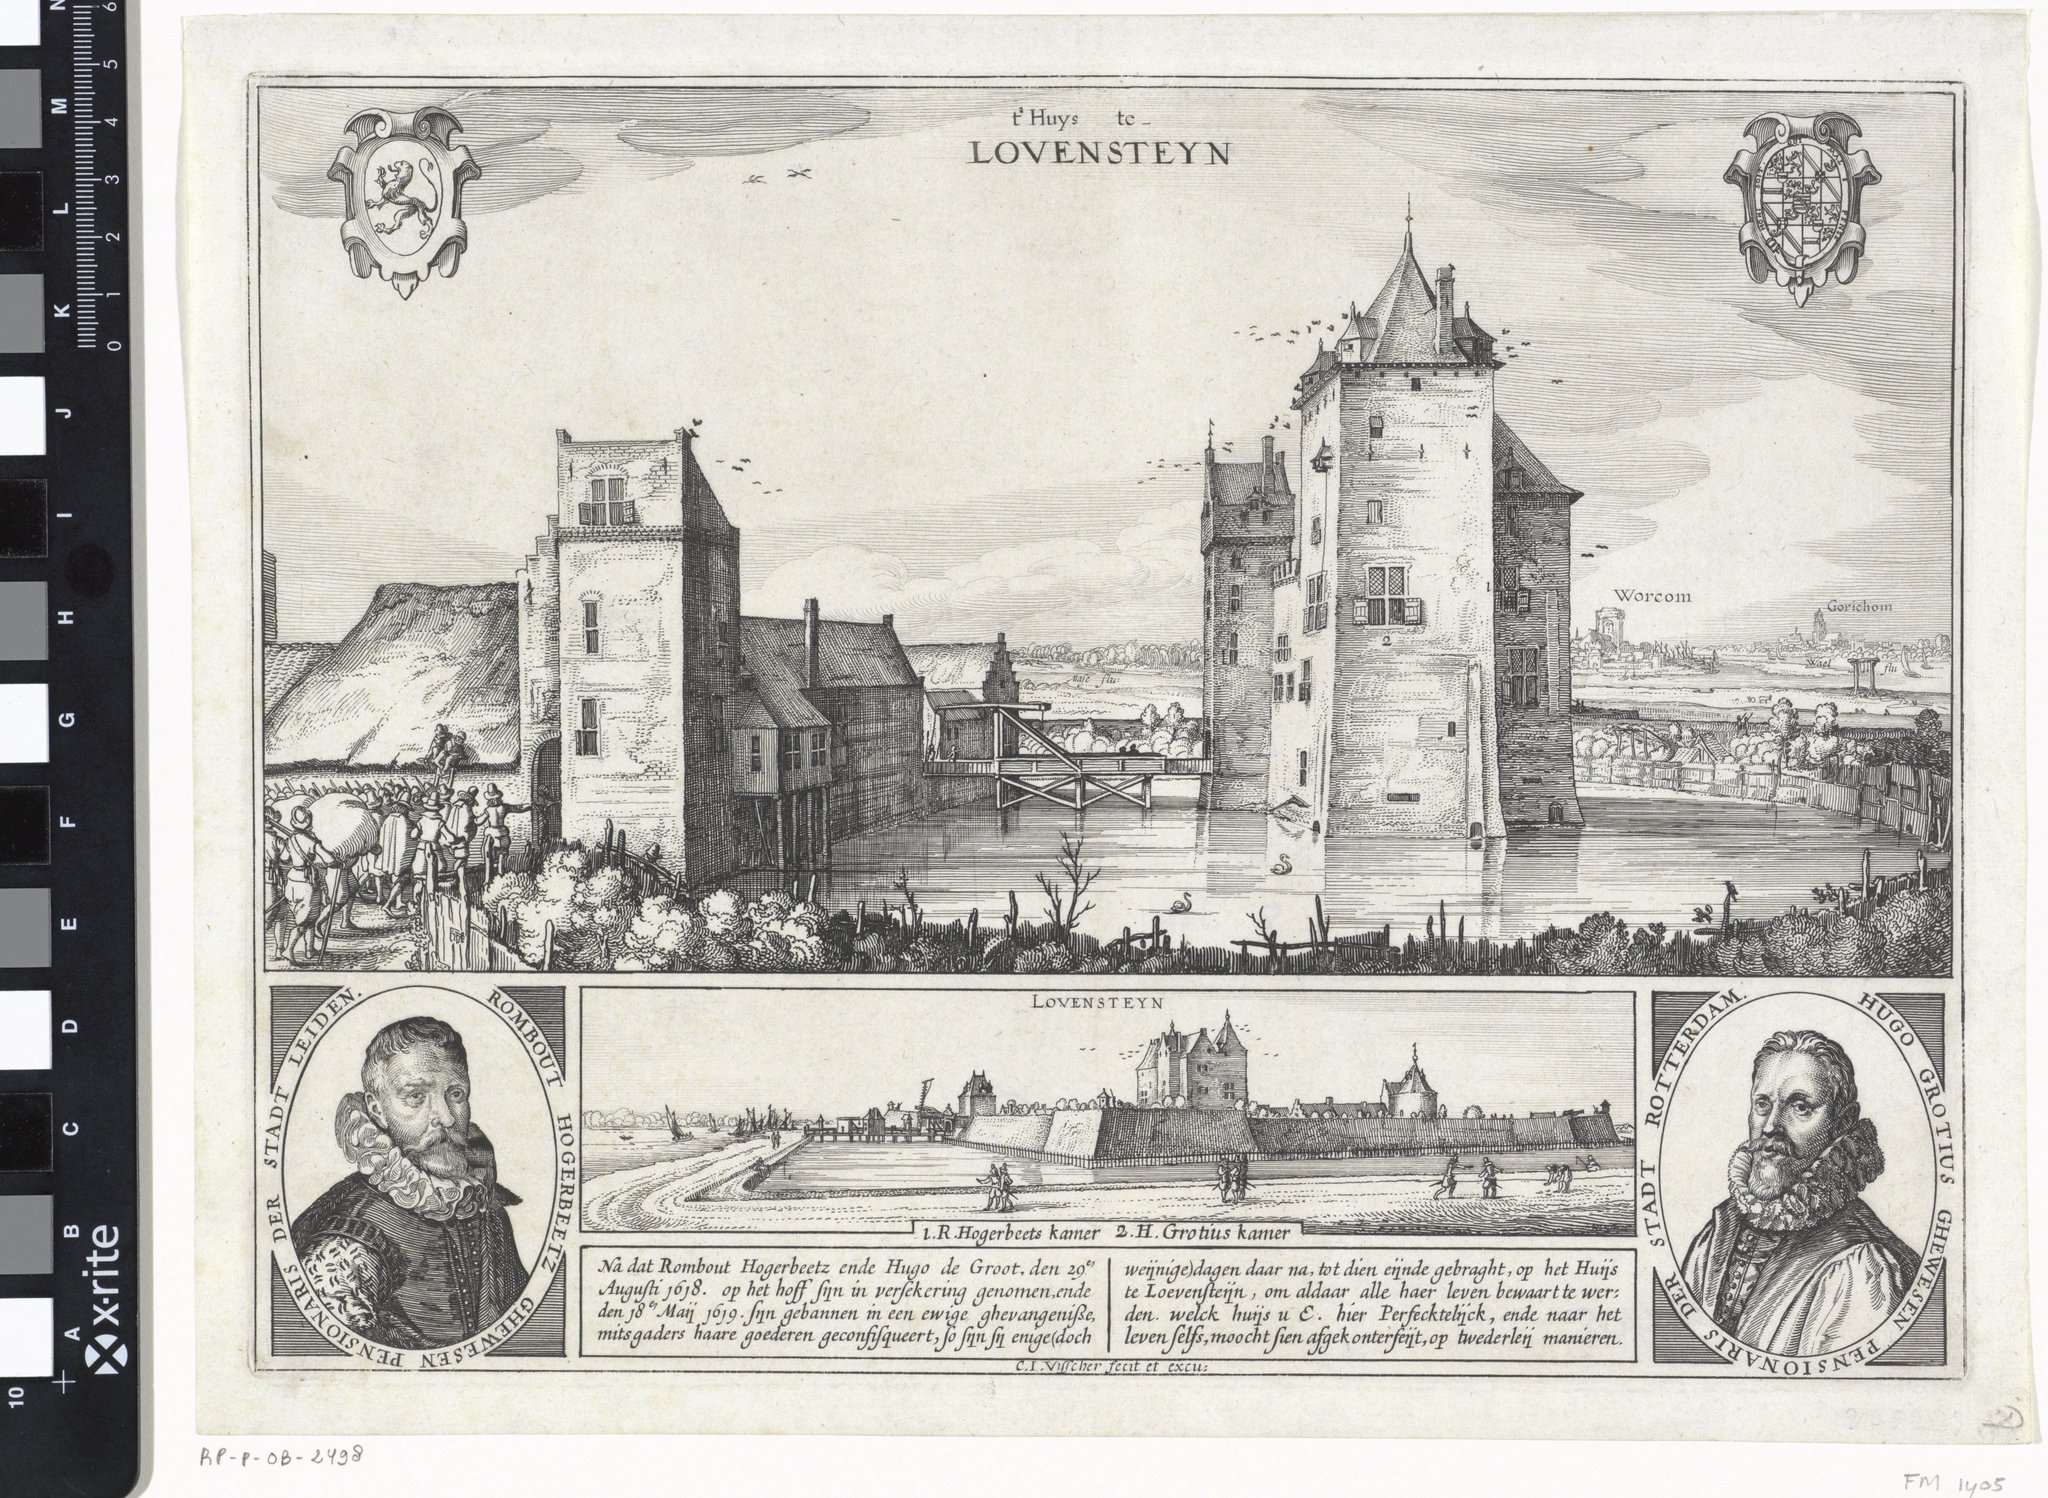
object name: print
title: Loevestein Castle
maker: claes jansz. visscher (ii)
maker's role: draughtsman, print maker, publisher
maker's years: 1586-1652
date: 1619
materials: paper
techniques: etching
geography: amsterdam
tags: delft, hugo de groot, hoorn (north holland), imprisonment, loevestein castle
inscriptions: collector's mark: Lugt 240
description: Roghman most likely took these two views of Loevestein Castle as his model when making his castle drawings. Just like Visscher, Roghman also varied and alternated his compositions. Hugo de Groot and Rombout Hogerbeets were imprisoned in Loevestein in 1619 for their political views. Engraved portraits of them flank the two views of the castle. At the left we see the prisoners arriving accompanied by soldiers.